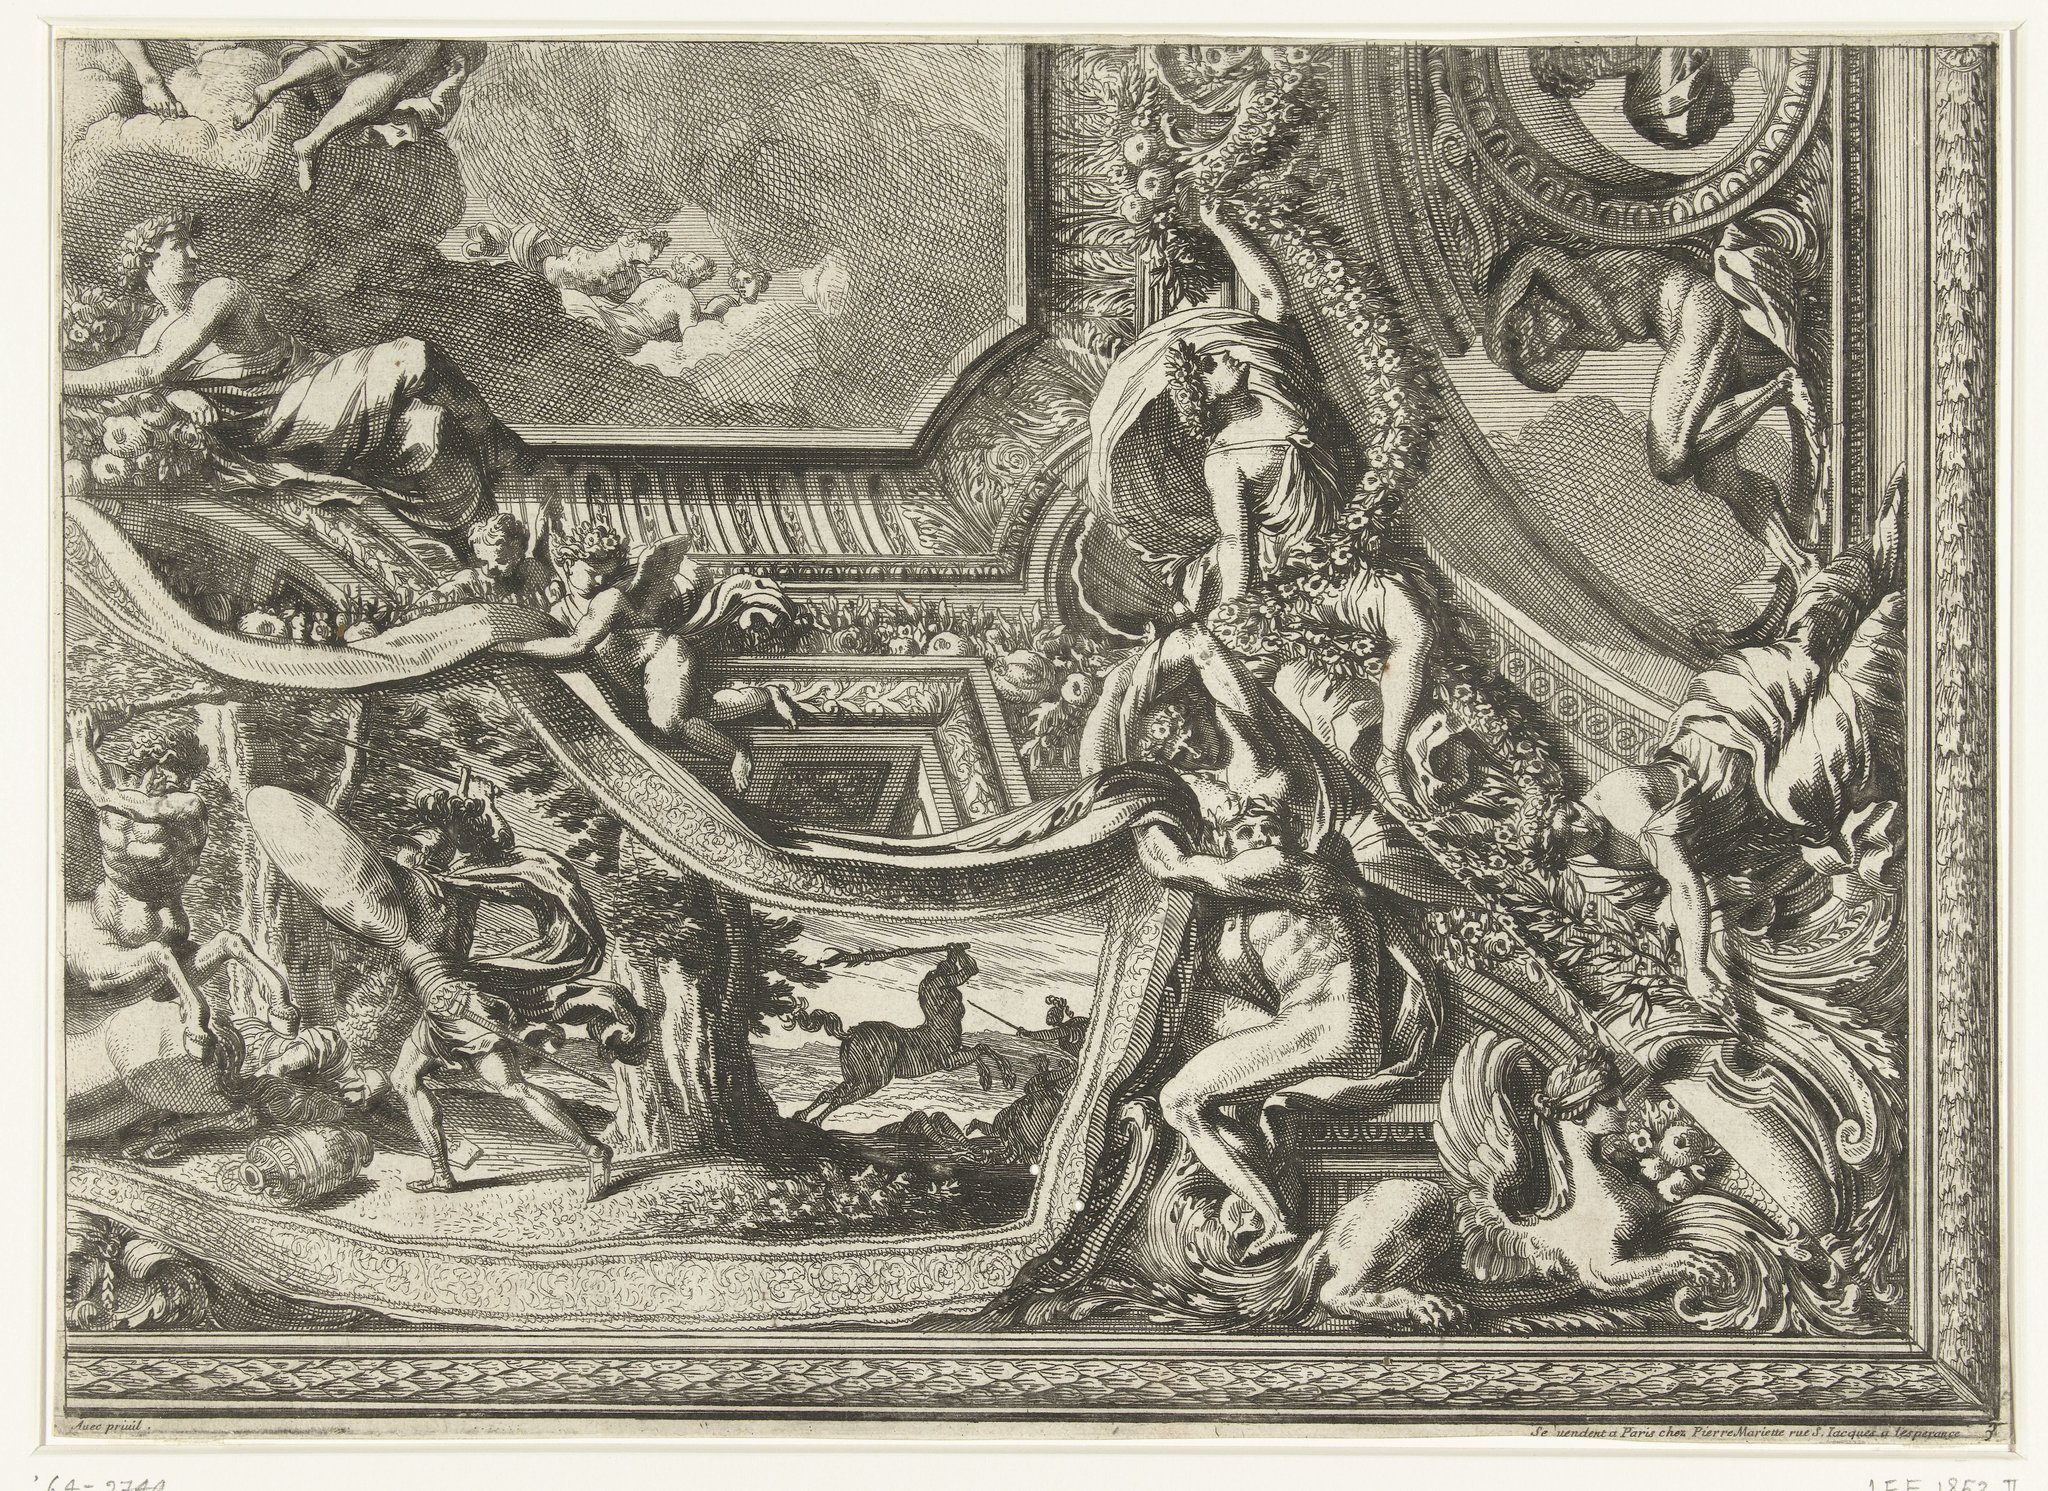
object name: print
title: Plafond met cartouche in vorm van wandtapijt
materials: paper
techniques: etching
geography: paris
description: Op de cartouche strijdt een Lapith tegen een Centaur. Plafond met varianten voor twee kwart gedeeltes van de rand. Blad 3 uit serie van 6 bladen met ontwerpen voor plafonds, sommige met varianten voor de randen. Uit tweede editie.